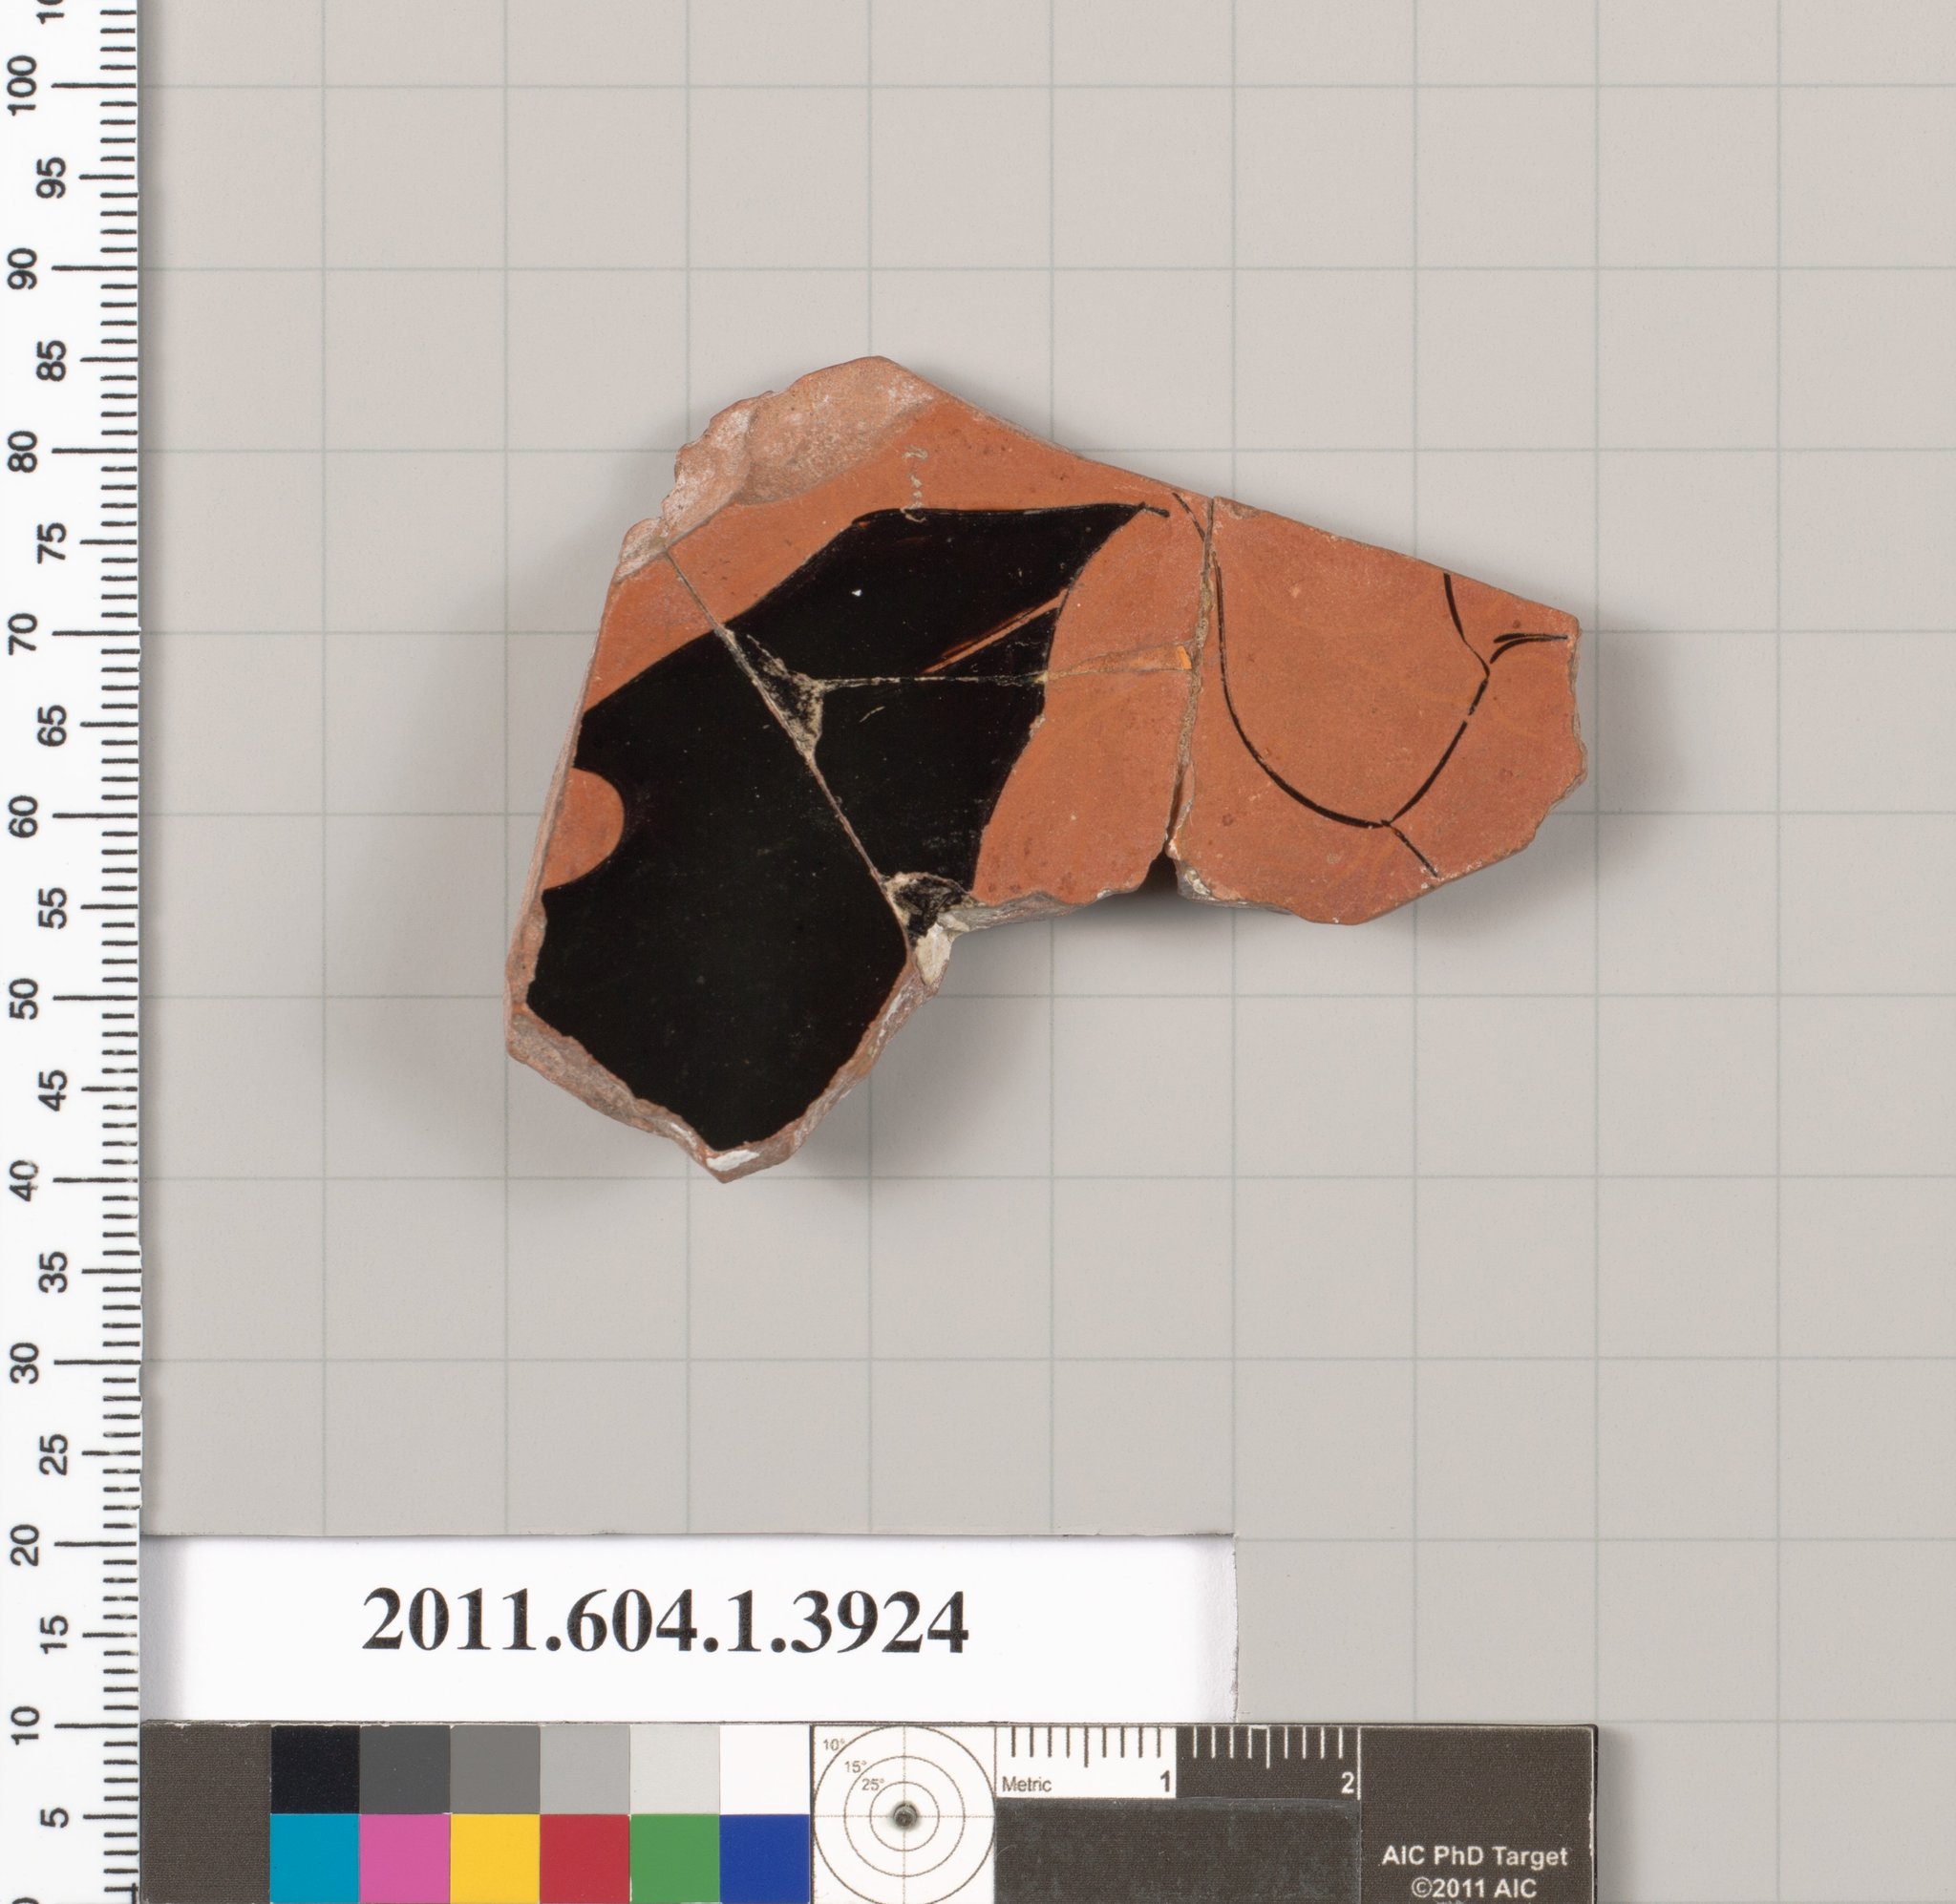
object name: kylix fragment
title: Terracotta fragment of a kylix (drinking cup)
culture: greek, attic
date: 500-476 BCE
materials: terracotta